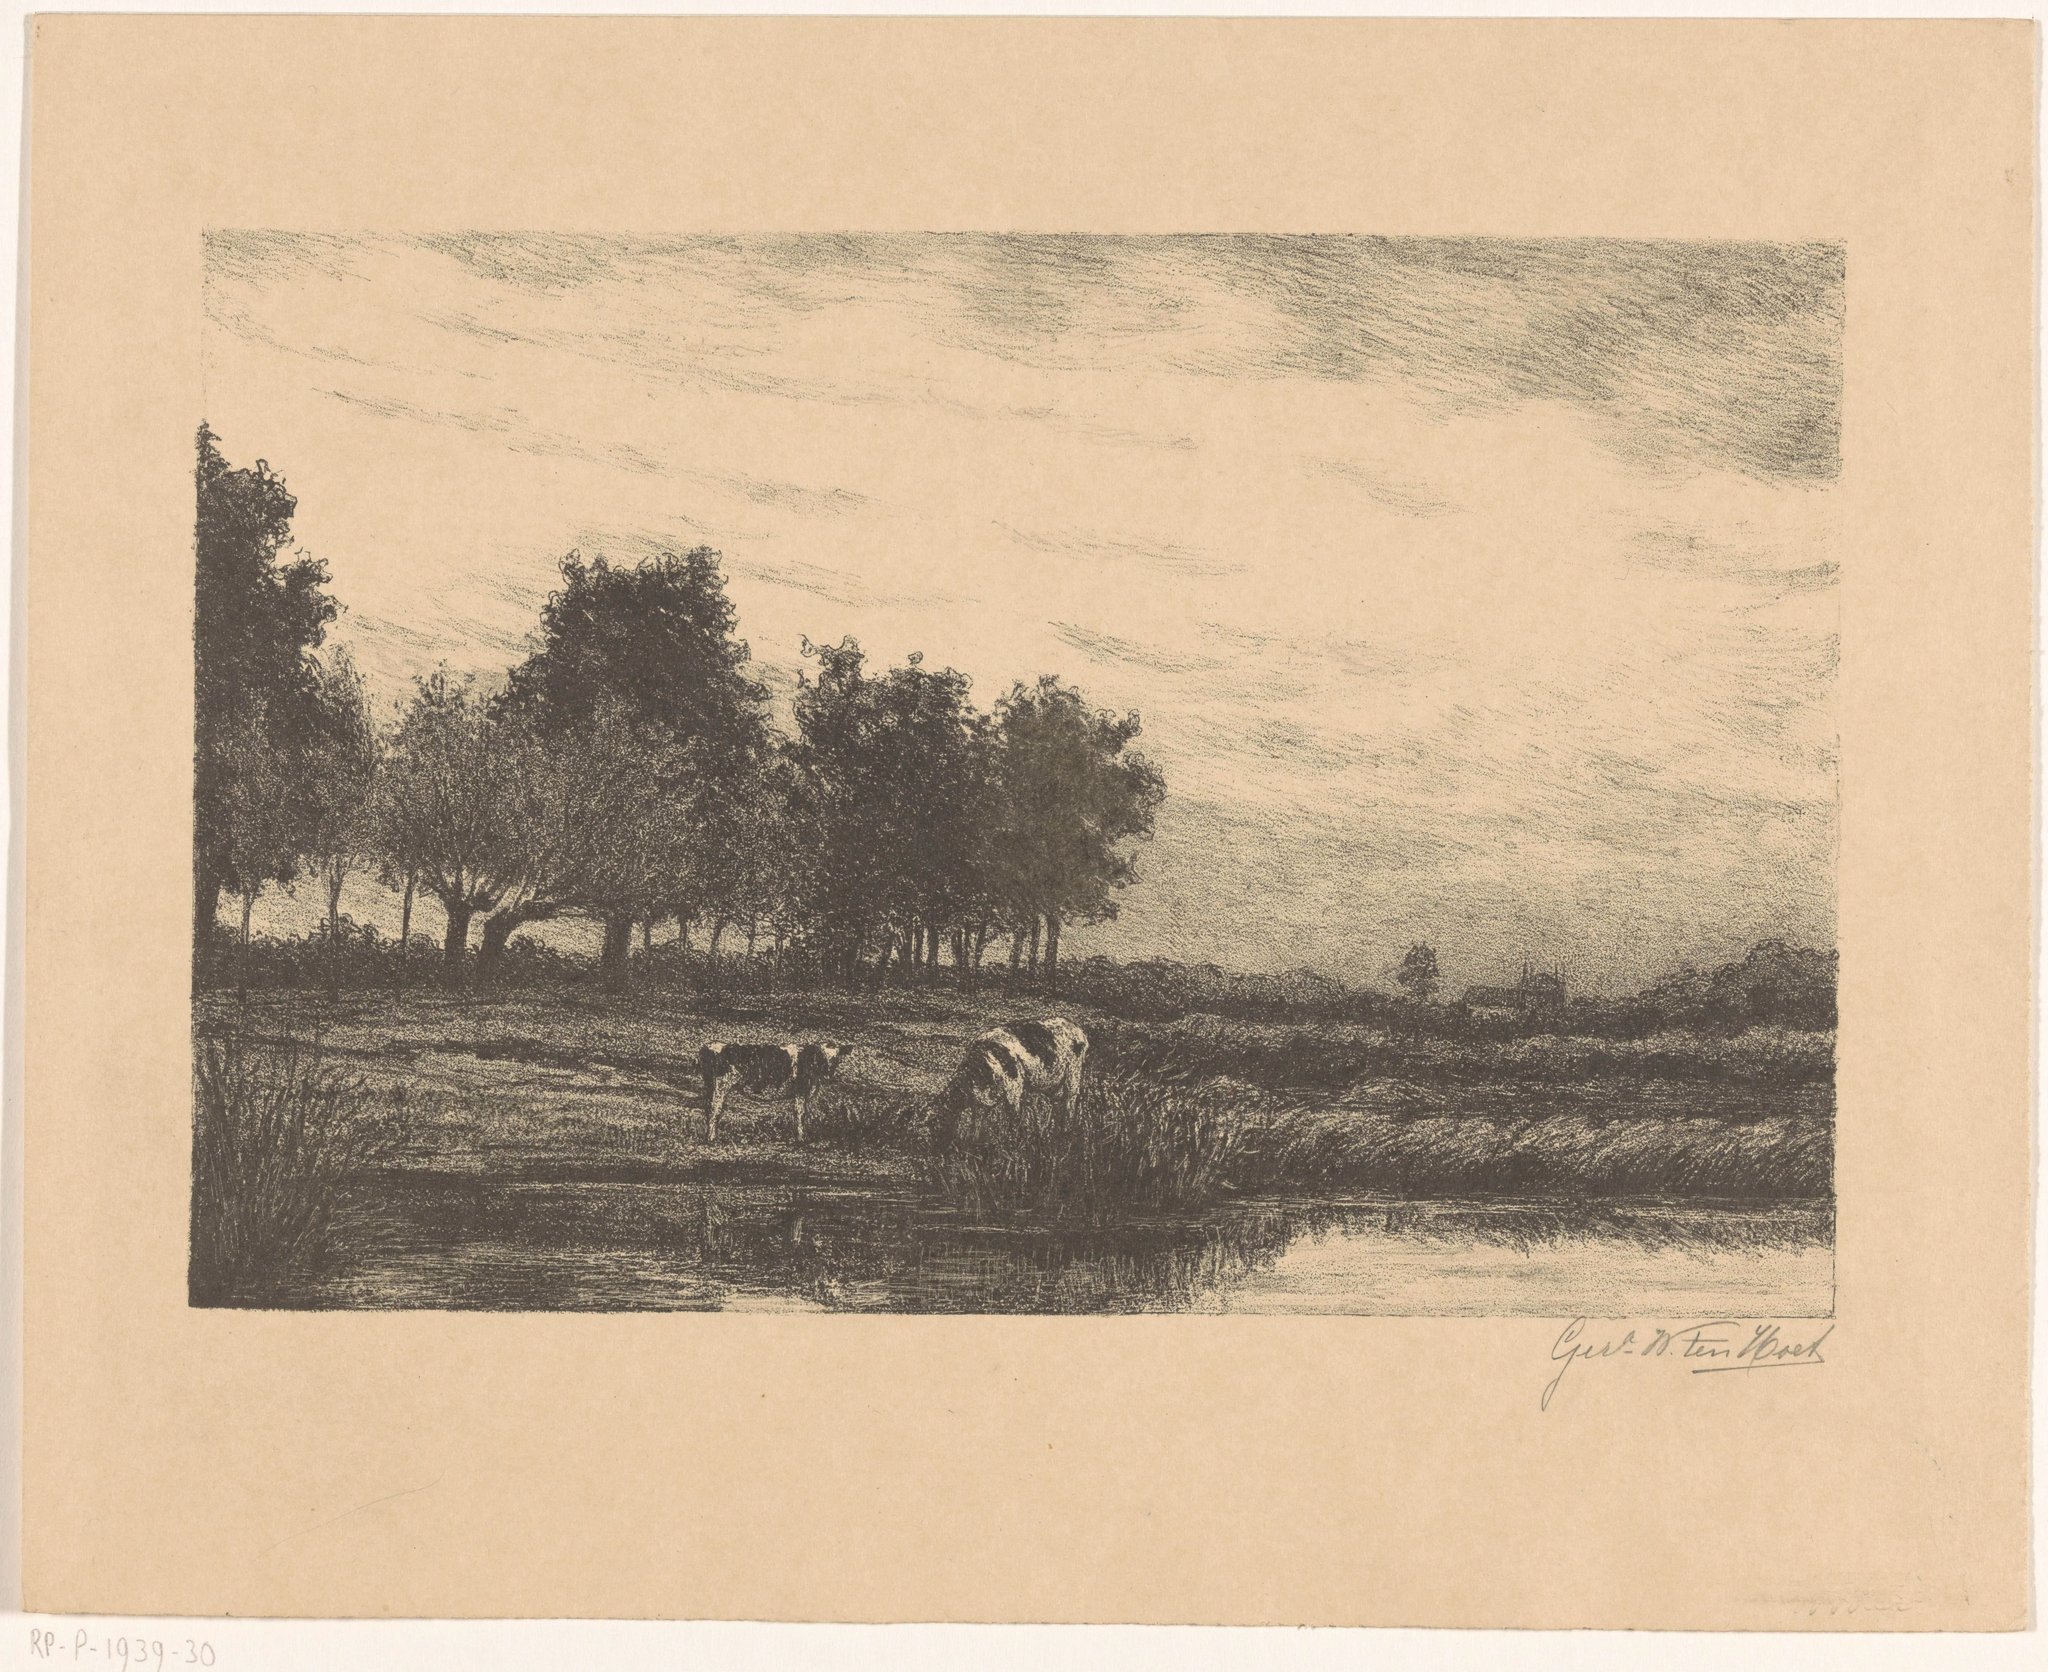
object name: print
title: Op de Veluwe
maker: gerarda wilhelmina ten hoet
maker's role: print maker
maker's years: 1857-1939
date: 1867-1939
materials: paper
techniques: lithograph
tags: cow, meadow, pasture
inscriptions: collector's mark: Lugt 2228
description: Twee koeien bij een plas. Links een rij bomen.